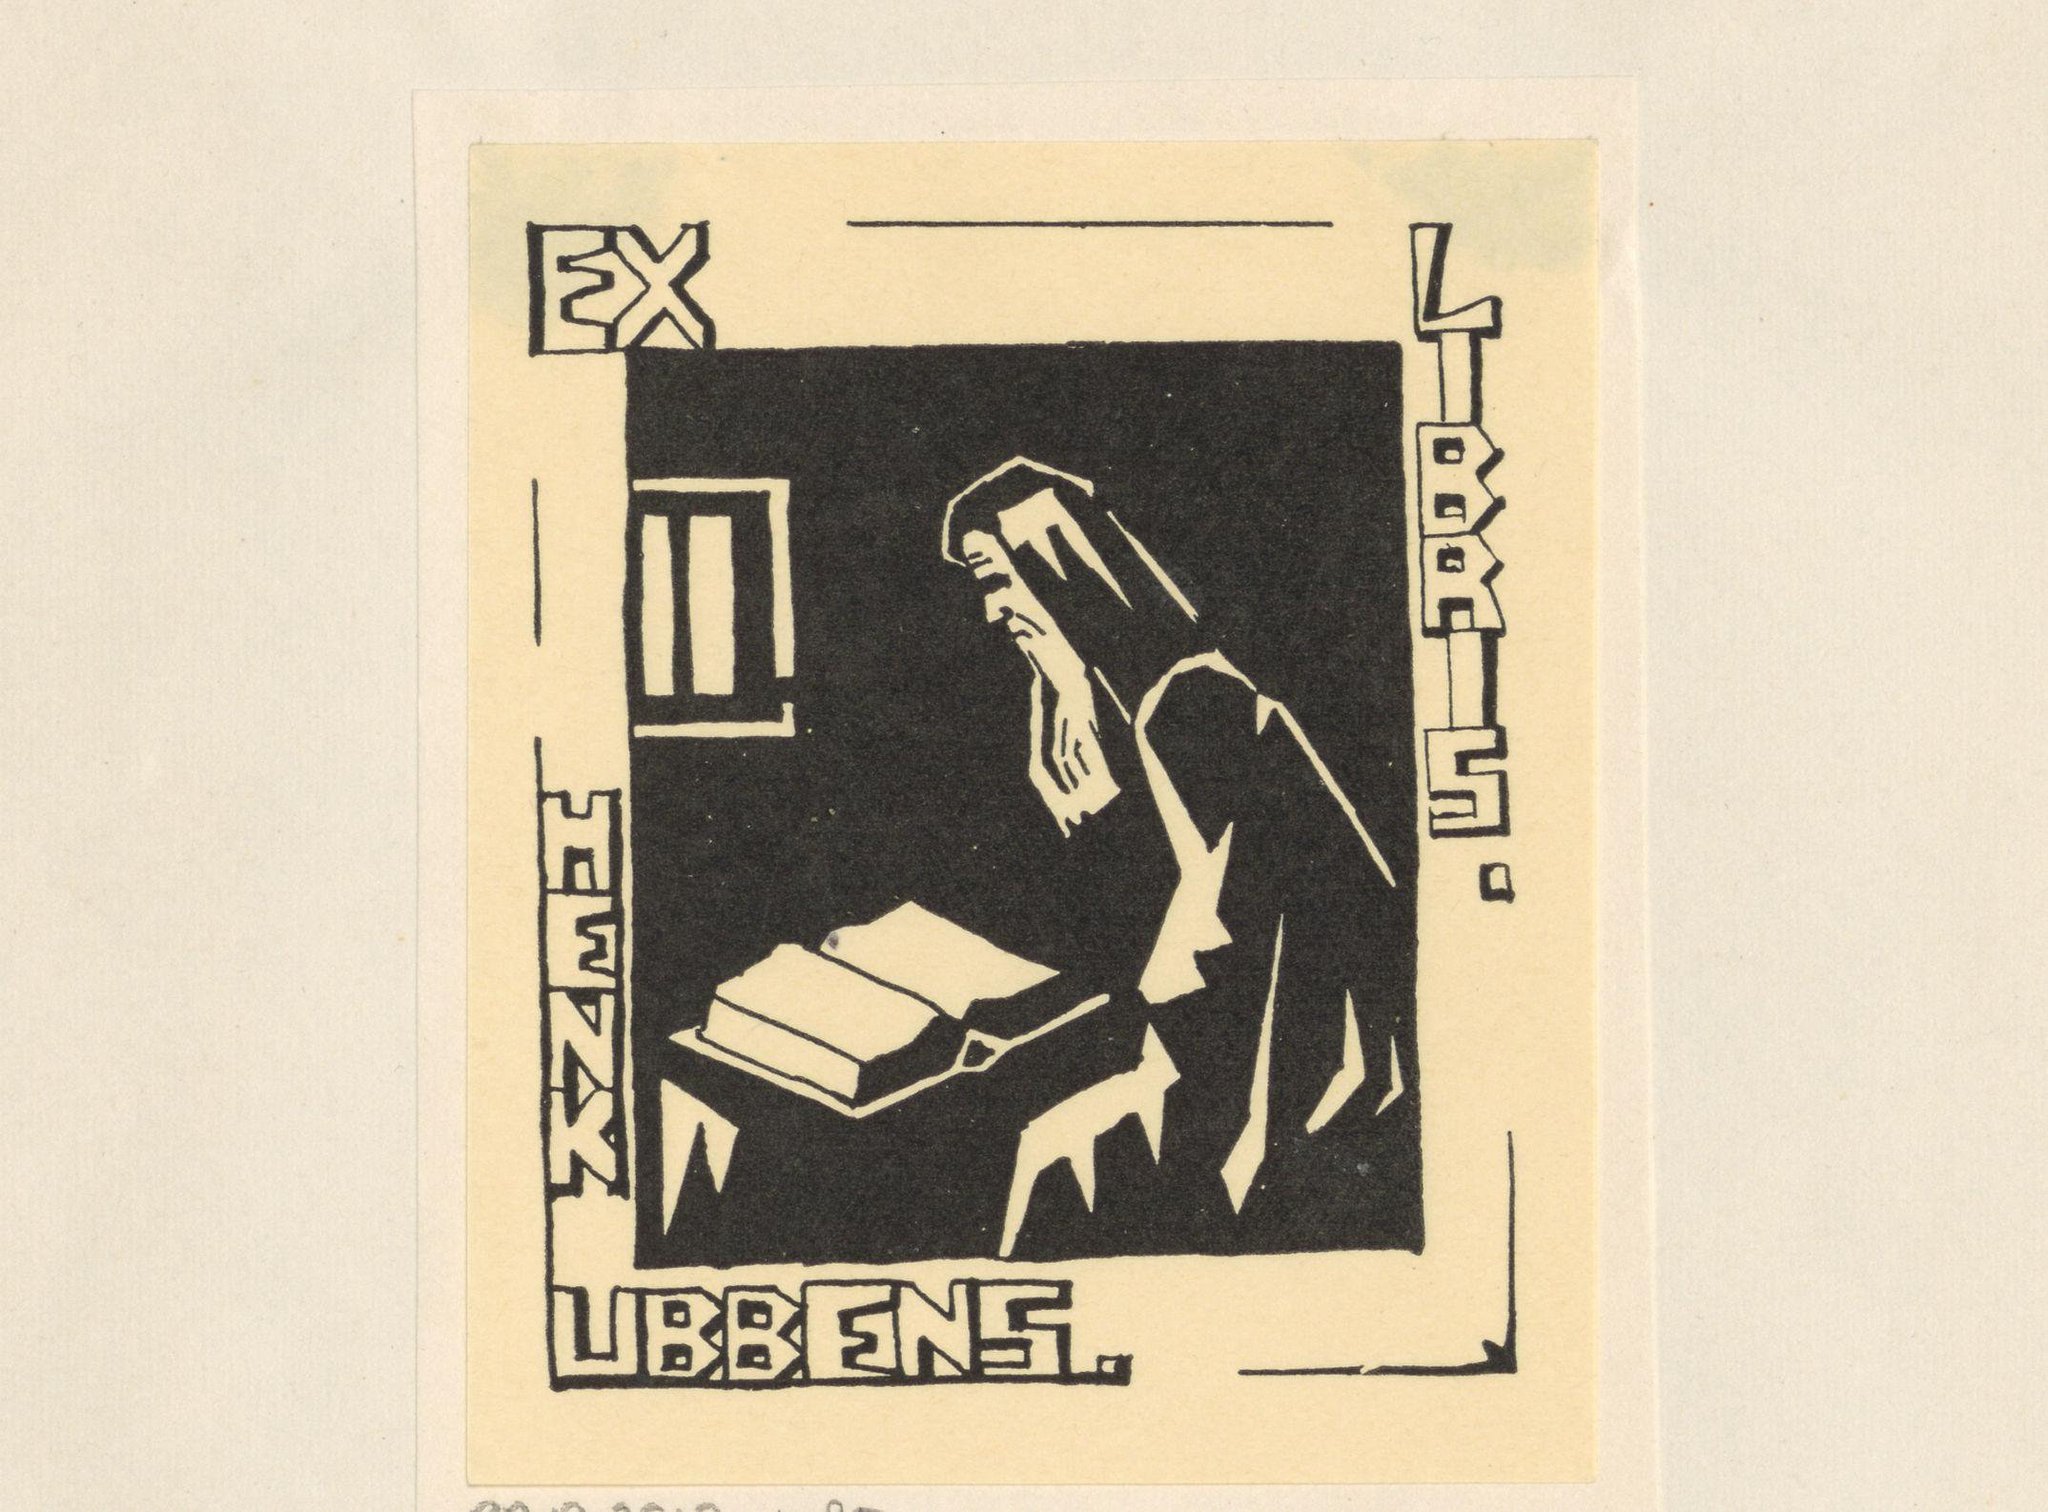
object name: bookplate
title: Ex libris van Henk Ubbens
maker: Anonymous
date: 1925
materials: paper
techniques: printing block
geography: netherlands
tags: reading, old man, closed window, prisoner in cell or locked place